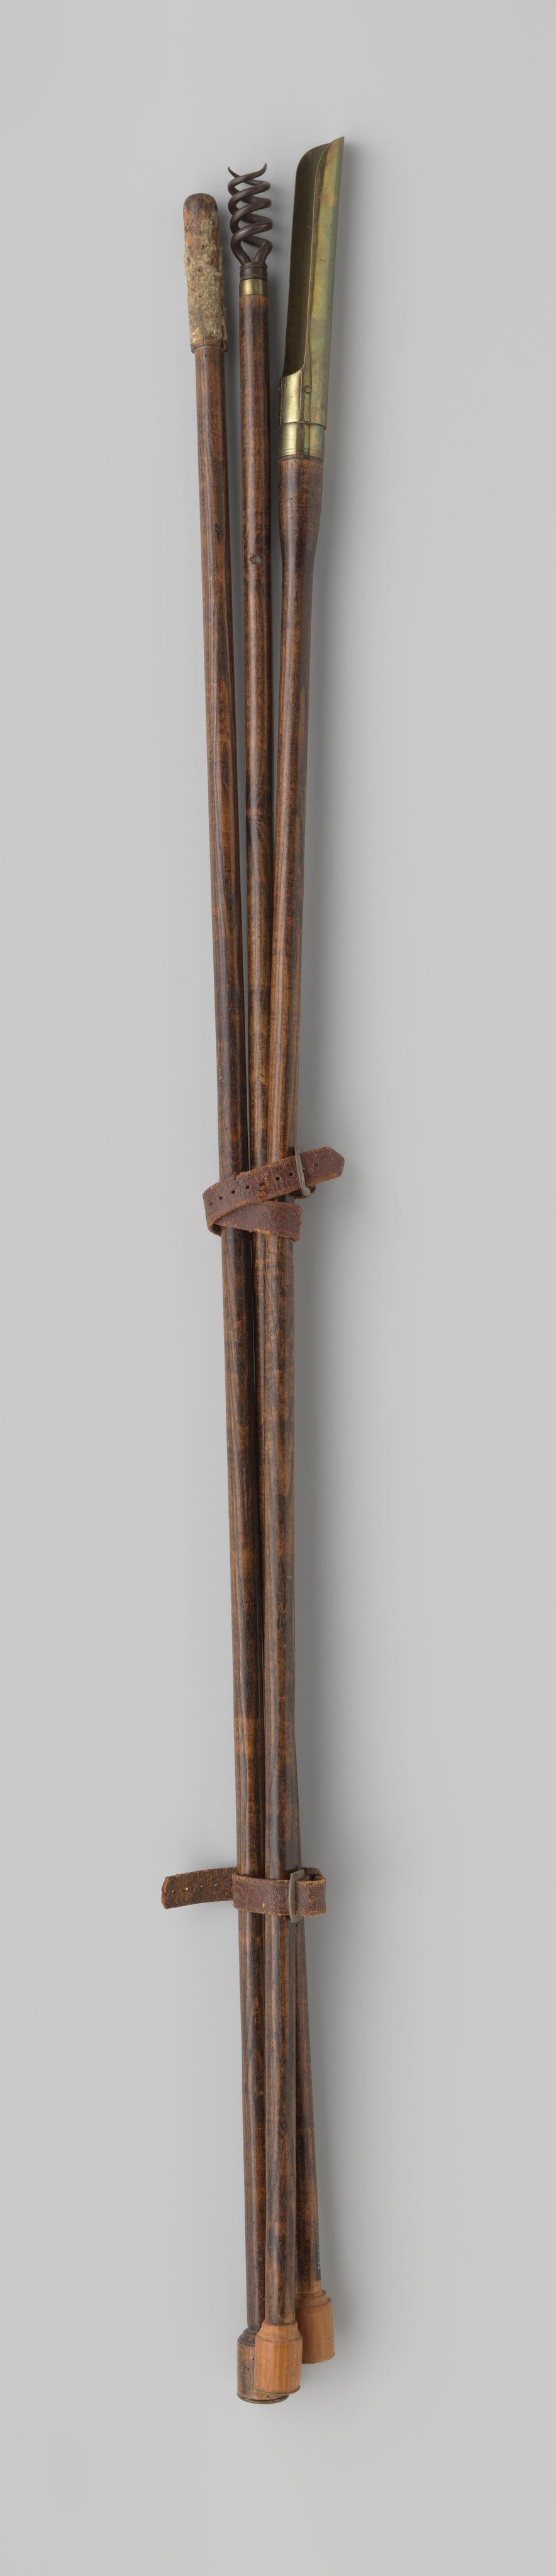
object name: aftrekker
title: Ronde houten stok waarop een puntig toelopende dubbele spiraal is gezet. Zgn. 'varkensstaart'.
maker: Anonymous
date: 1700-1800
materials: copper, leather, wood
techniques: cutting, forging, striking, turning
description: Ronde houten stok waarop een puntig toelopende dubbele spiraal is gezet. Onder de basis van de spiraal zit een koperen ring om de schacht. Onderaan de schacht zit een klos met vlakke onderkant. Op de onderkant is een koperen plaatje geslagen.